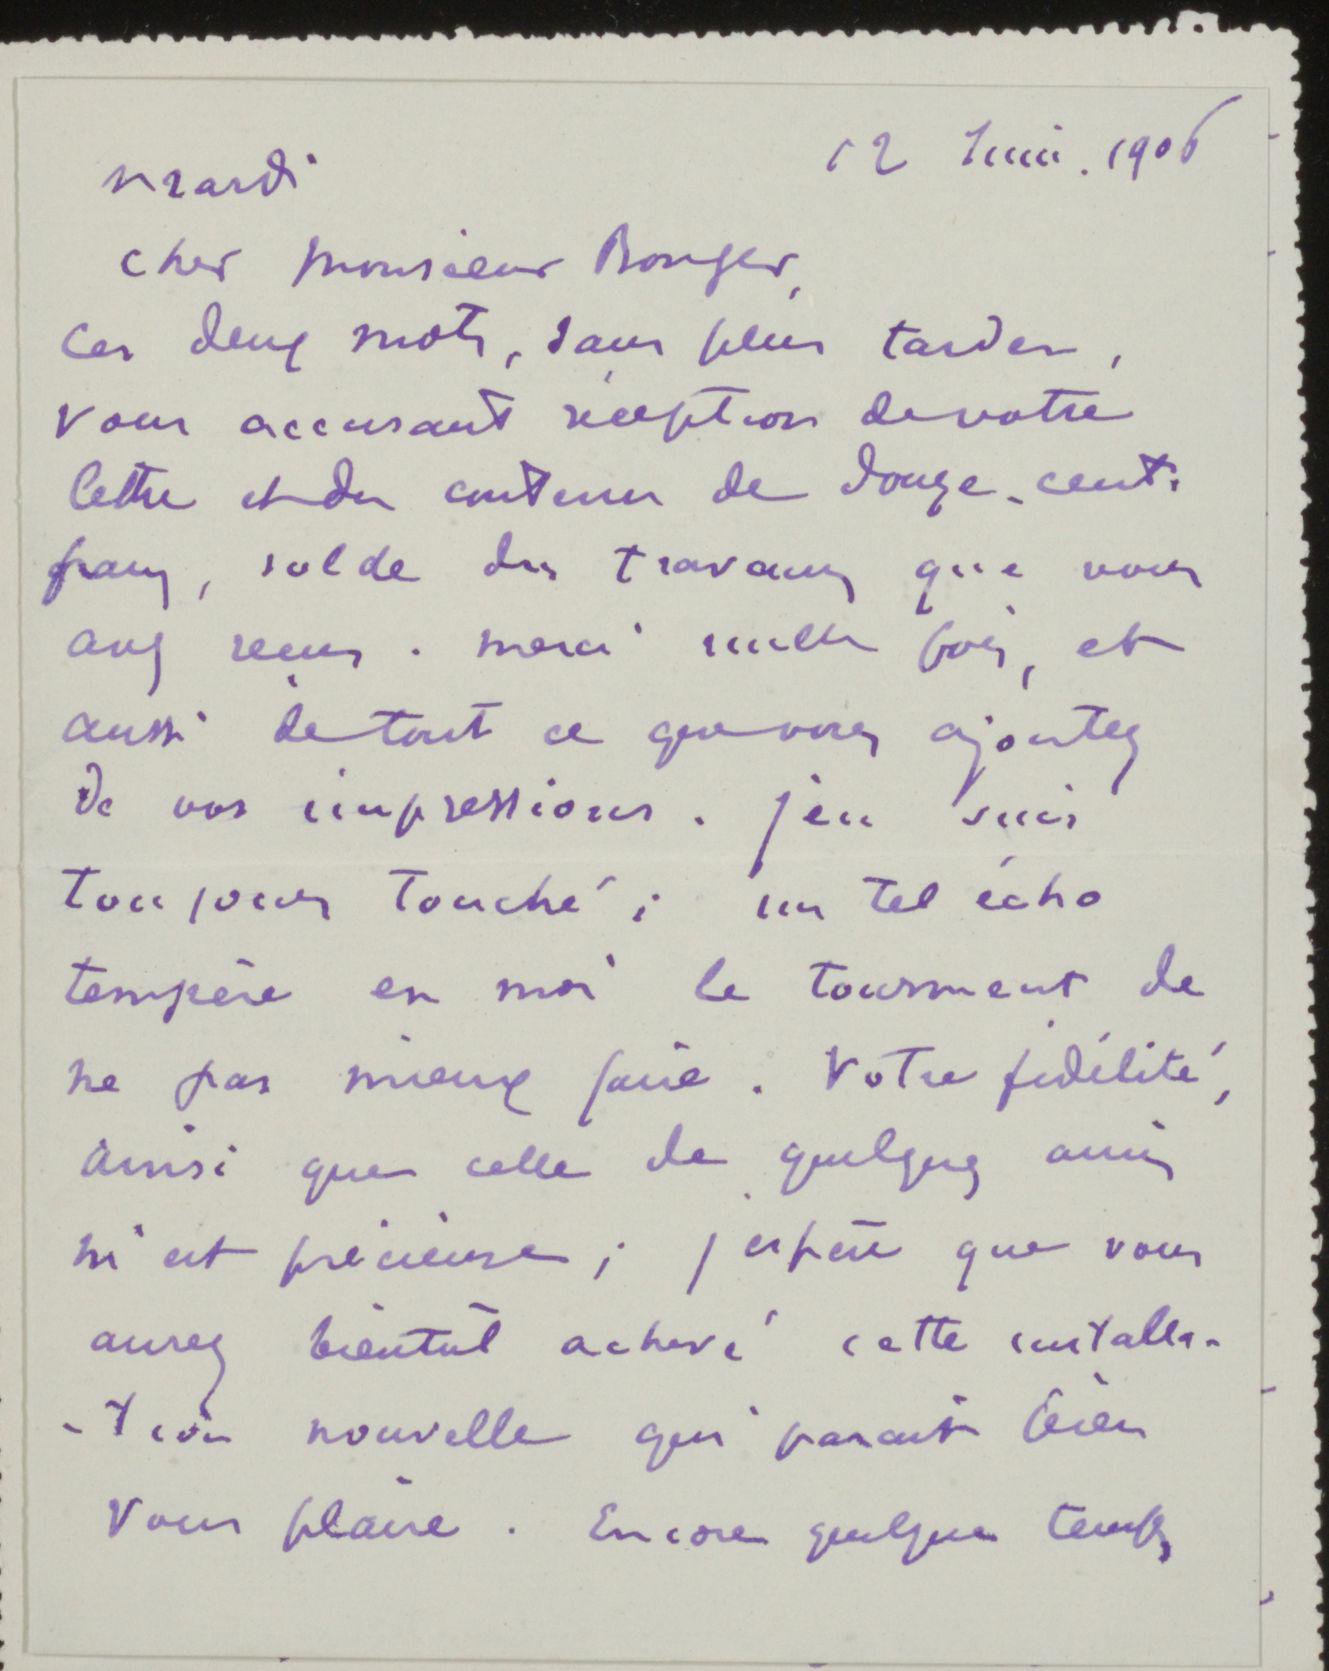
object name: letter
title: Brief aan Andries Bonger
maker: odilon redon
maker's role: draughtsman, painter, print maker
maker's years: 1840-1916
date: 1906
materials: ink, paper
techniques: pen, writing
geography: paris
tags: camille redon-falte, arï redon, lille, paris, print maker, émile bernard, amsterdam, andries bonger, money, netherlands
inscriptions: watermark